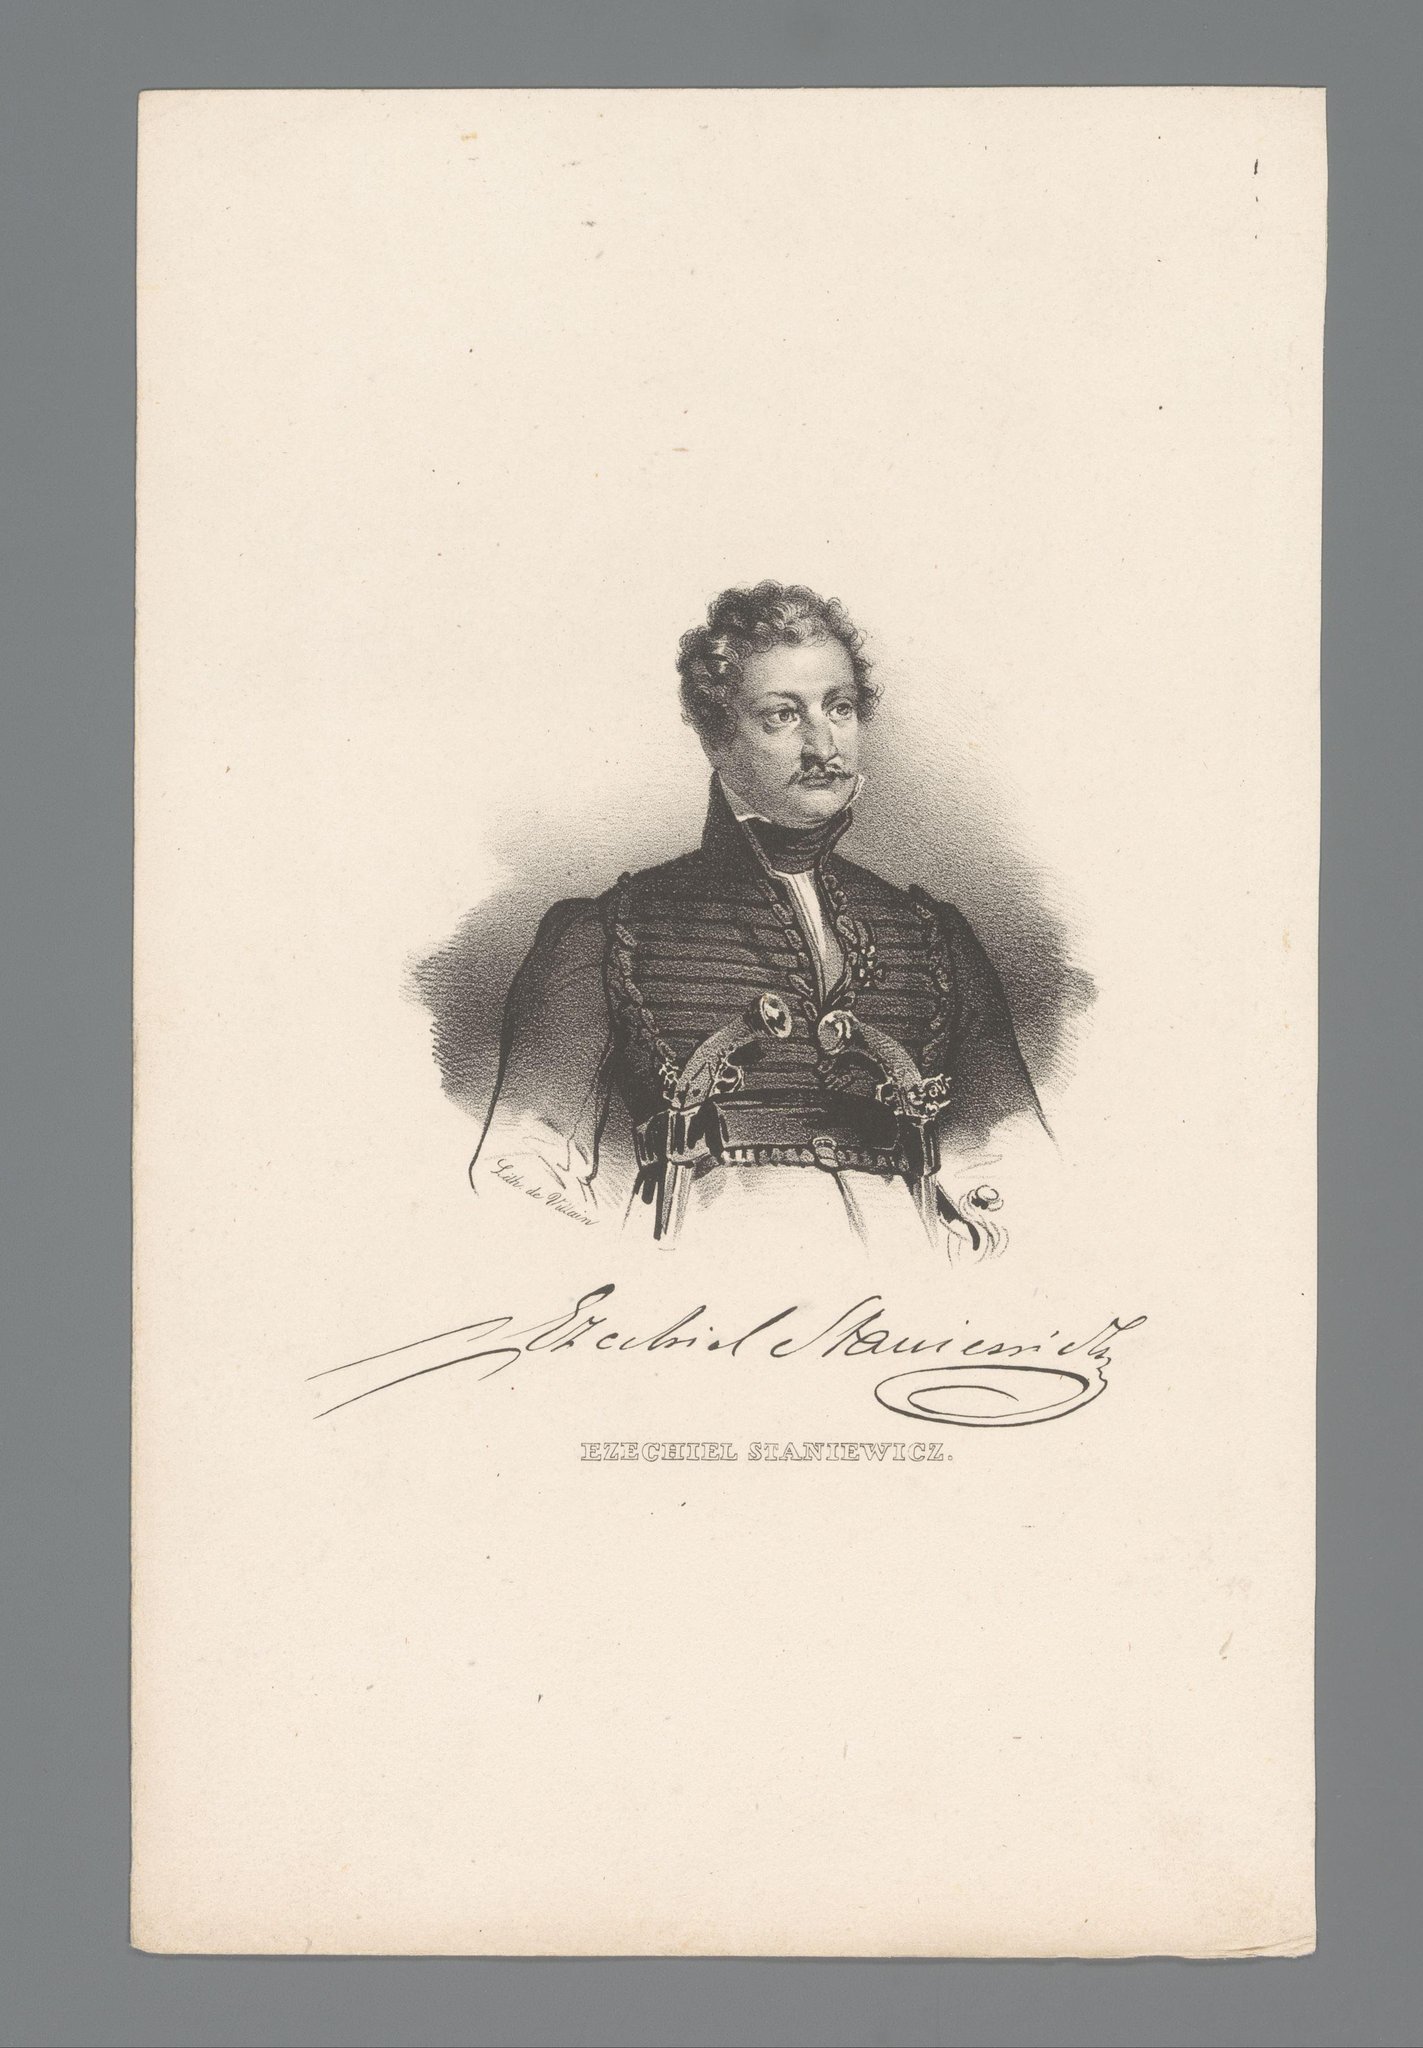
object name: print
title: Ezechiel Staniewicz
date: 1832-1839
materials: paper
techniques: lithograph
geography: paris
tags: historical persons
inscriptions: collector's mark: Lugt 2228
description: Prent uit: Straszewicz., Joseph. Les polonais et les polonaises de la révolution du 29 novembre 1830, ou Portraits des personnes qui ont figuré dans la dernière guerre de l'indépendance polonaise, avec les fac-simile de leur signature, lithographiés sur dessins originaux, par les artistes les plus distingués: MM. Grévedon, Maurin, Vigneron, Belliard, Devéria, Bazin, Desmadryl, Lecler, Desmaisons, Rutowski, officier polonais, etc,. etc., accompagnés d'une biographie pour chaque portrait. Parijs: Catherine-Anaïs Pinard, 1832. Of uit: Straszewicz., Joseph. Les polonais et les polonaises de la révolution du 29 novembre 1830. Biographie des personnes qui ont figuré dans la dernière guerre de l'indépendance polonaise, avec les fac-simile de leur signature, ornée de 30 portraits lithographiés sur dessins originaux, par les artistes les plus distingués: MM. Grévedon, Maurin, Vigneron, Belliard, Devéria, Bazin, Desmadryl, Lecler, etc., etc.. Parijs: s.n., 1839.